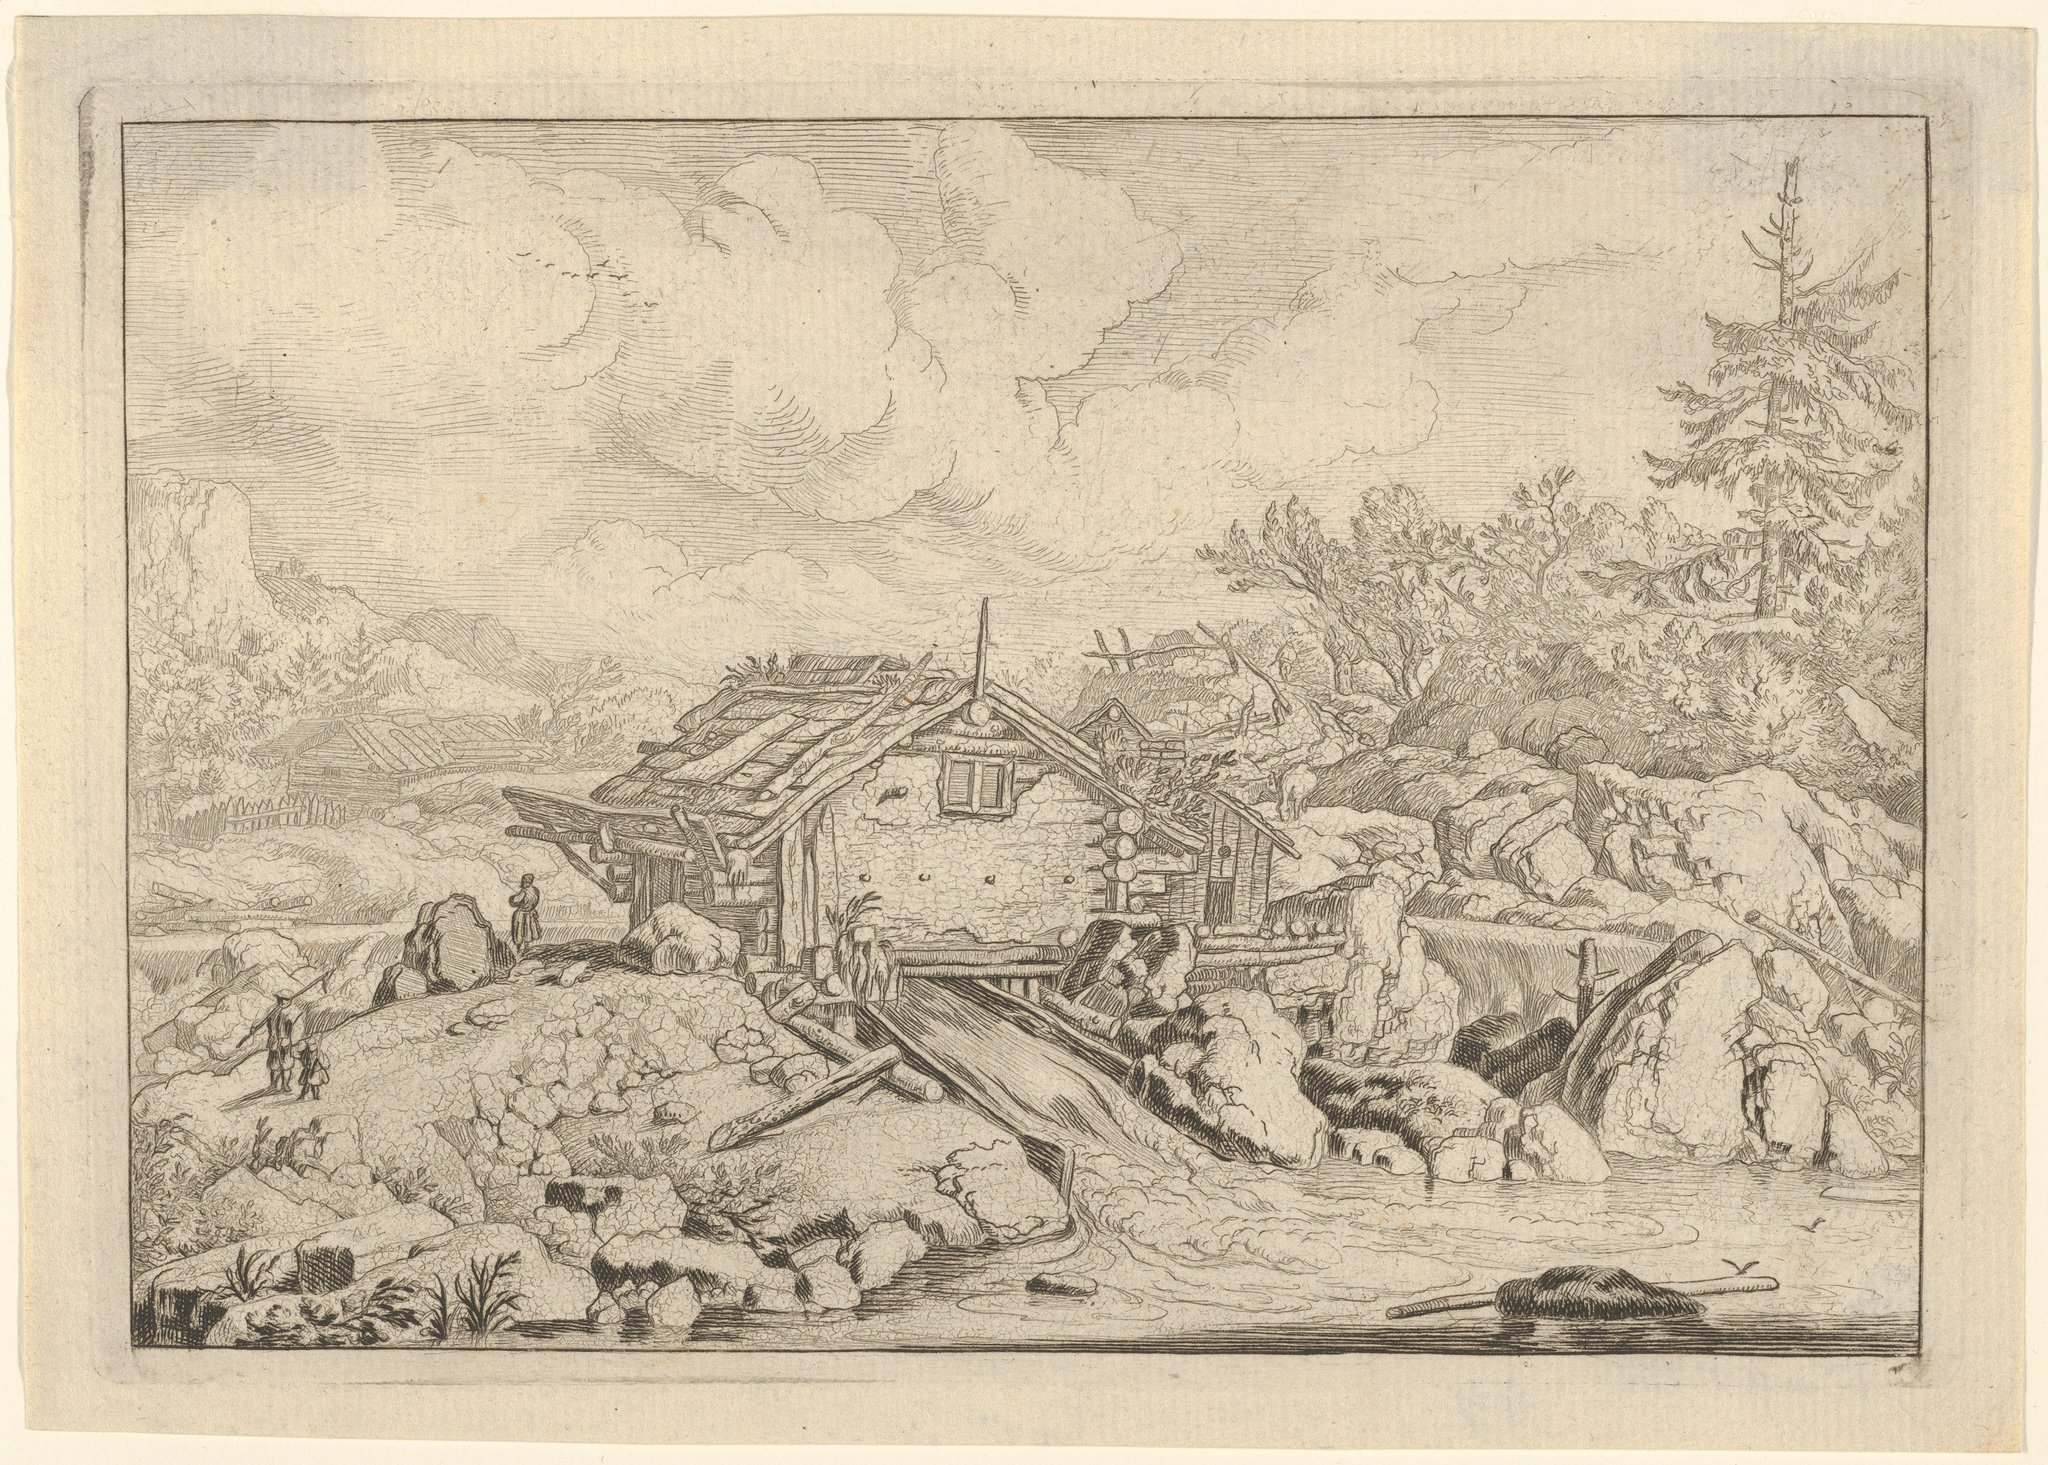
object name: print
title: The Watermill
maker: allart van everdingen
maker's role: artist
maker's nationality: dutch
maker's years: 1621-1675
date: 1621-1675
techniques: engraving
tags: watermills,landscapes,trees